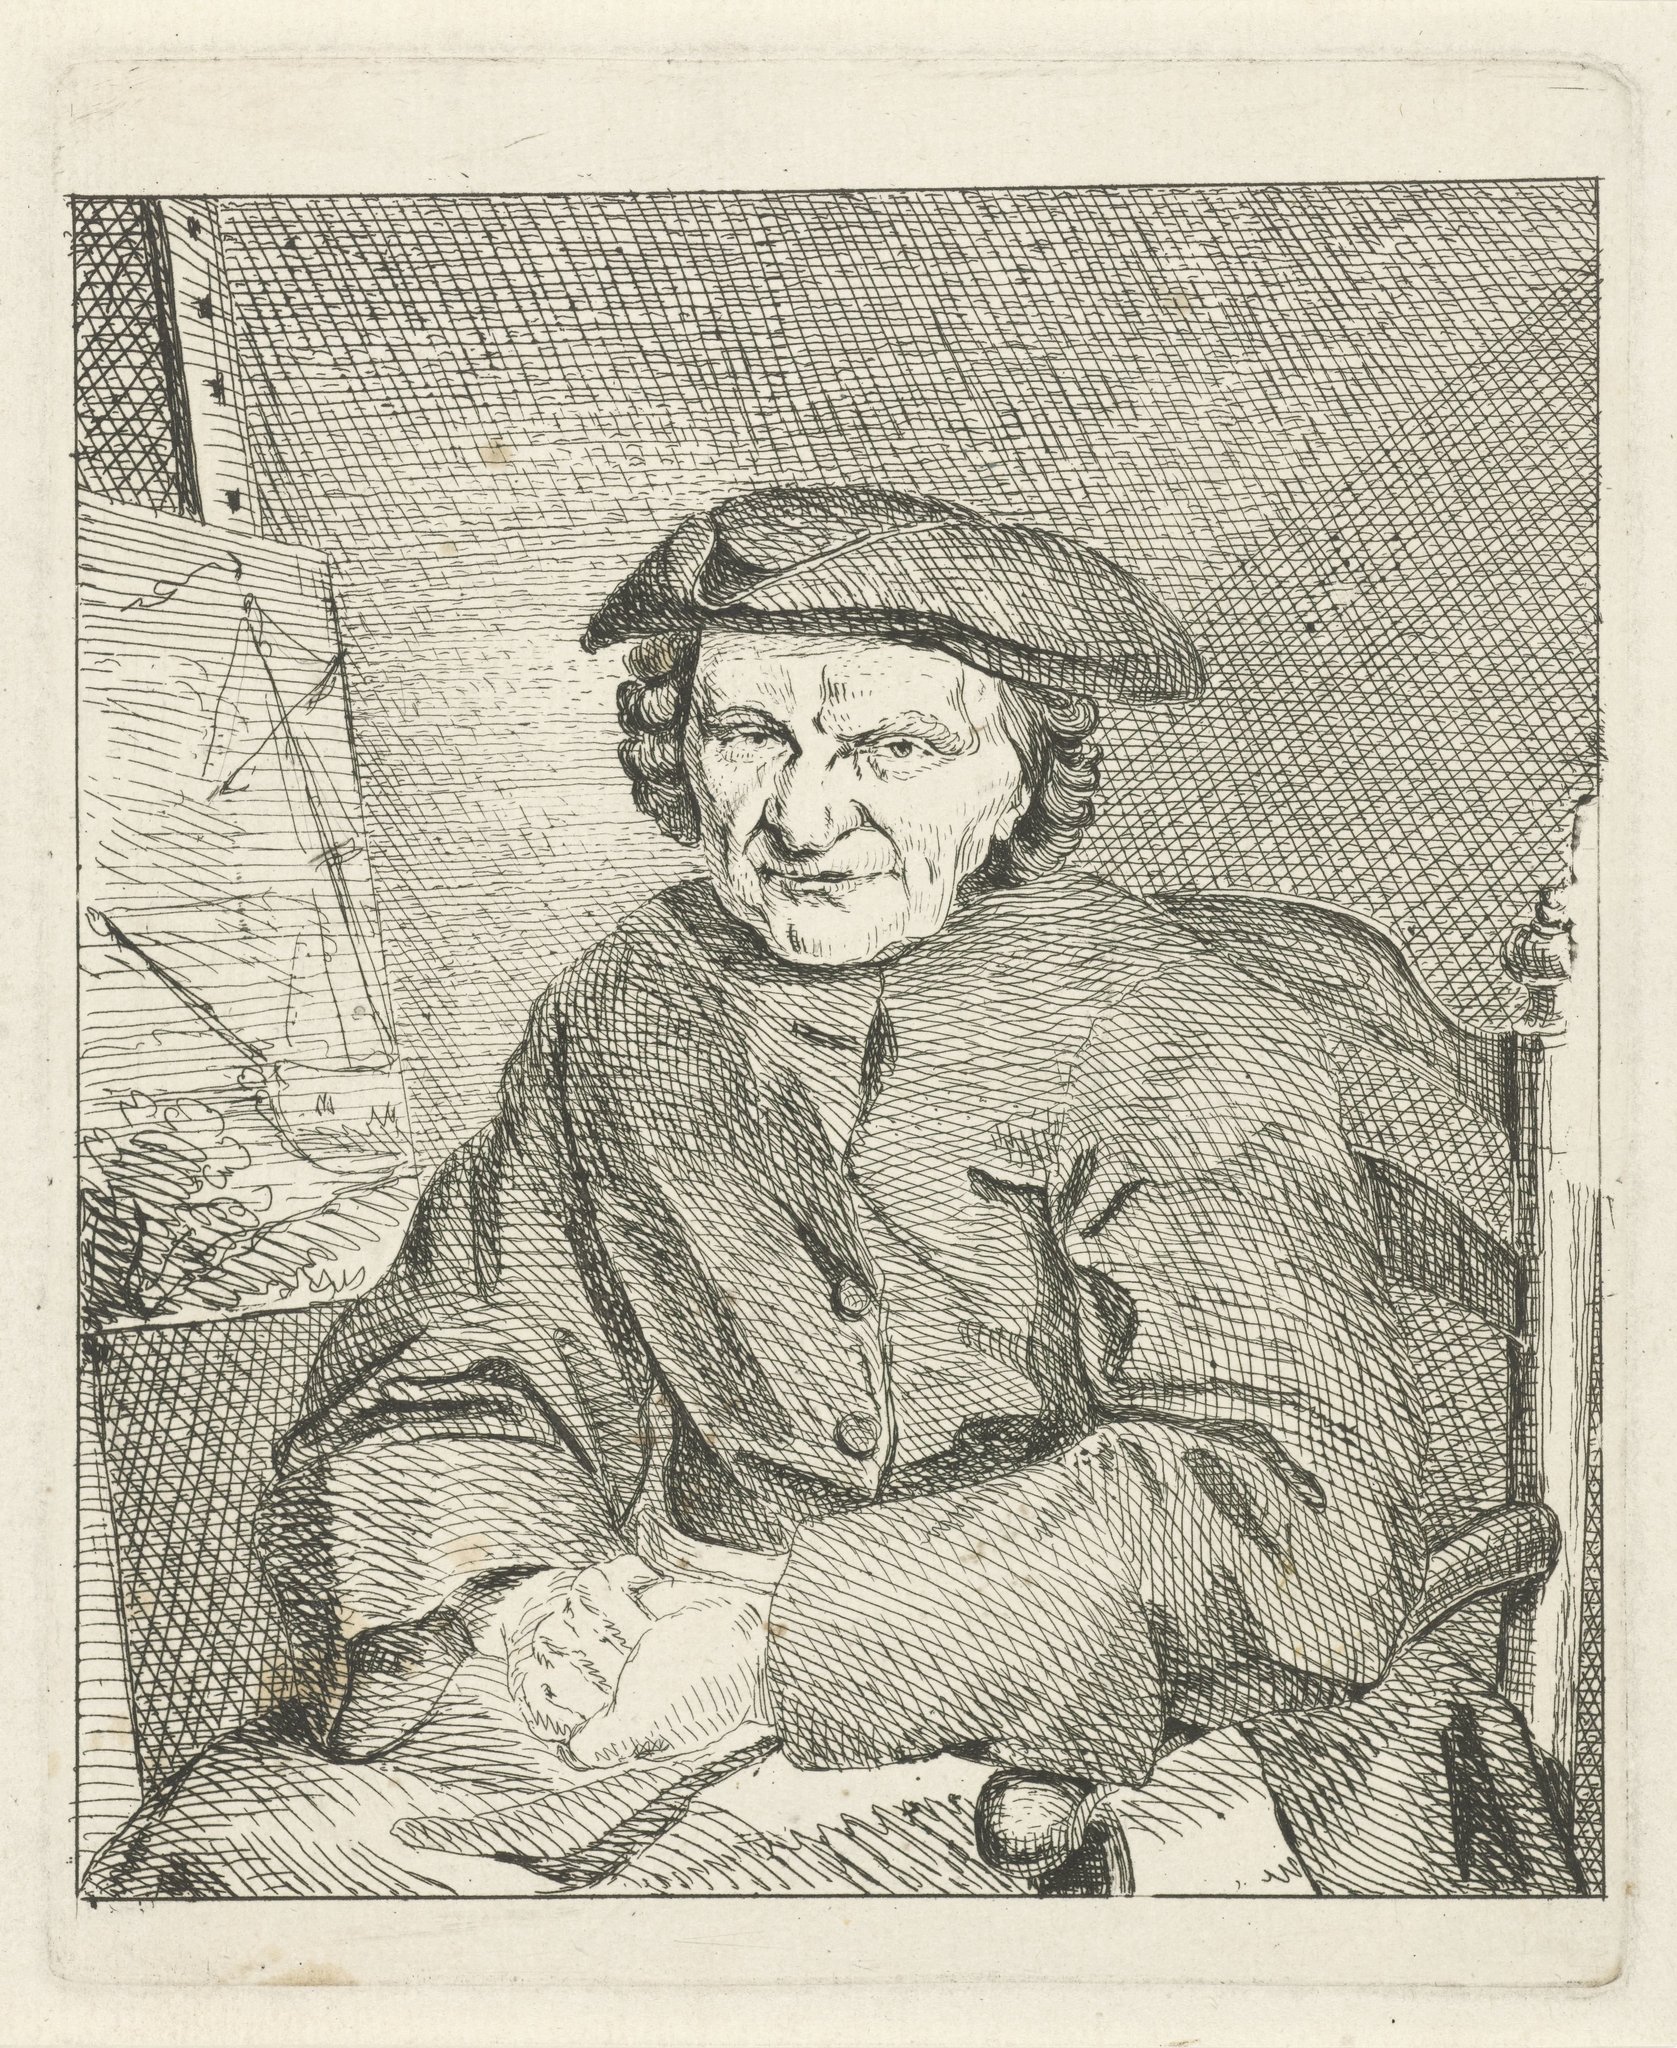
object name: print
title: Portret van Adam Silo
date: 1766-1783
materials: paper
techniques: etching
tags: print maker, adam silo, portrait, self-portrait of painter, easel (+ paint ~ arts)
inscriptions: collector's mark: Lugt 2228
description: Adam Silo, schilder en prentmaker, zittend op een stoel ten halven lijve naar links. Naast hem een schildersezel met een schilderij van een schip op zee.